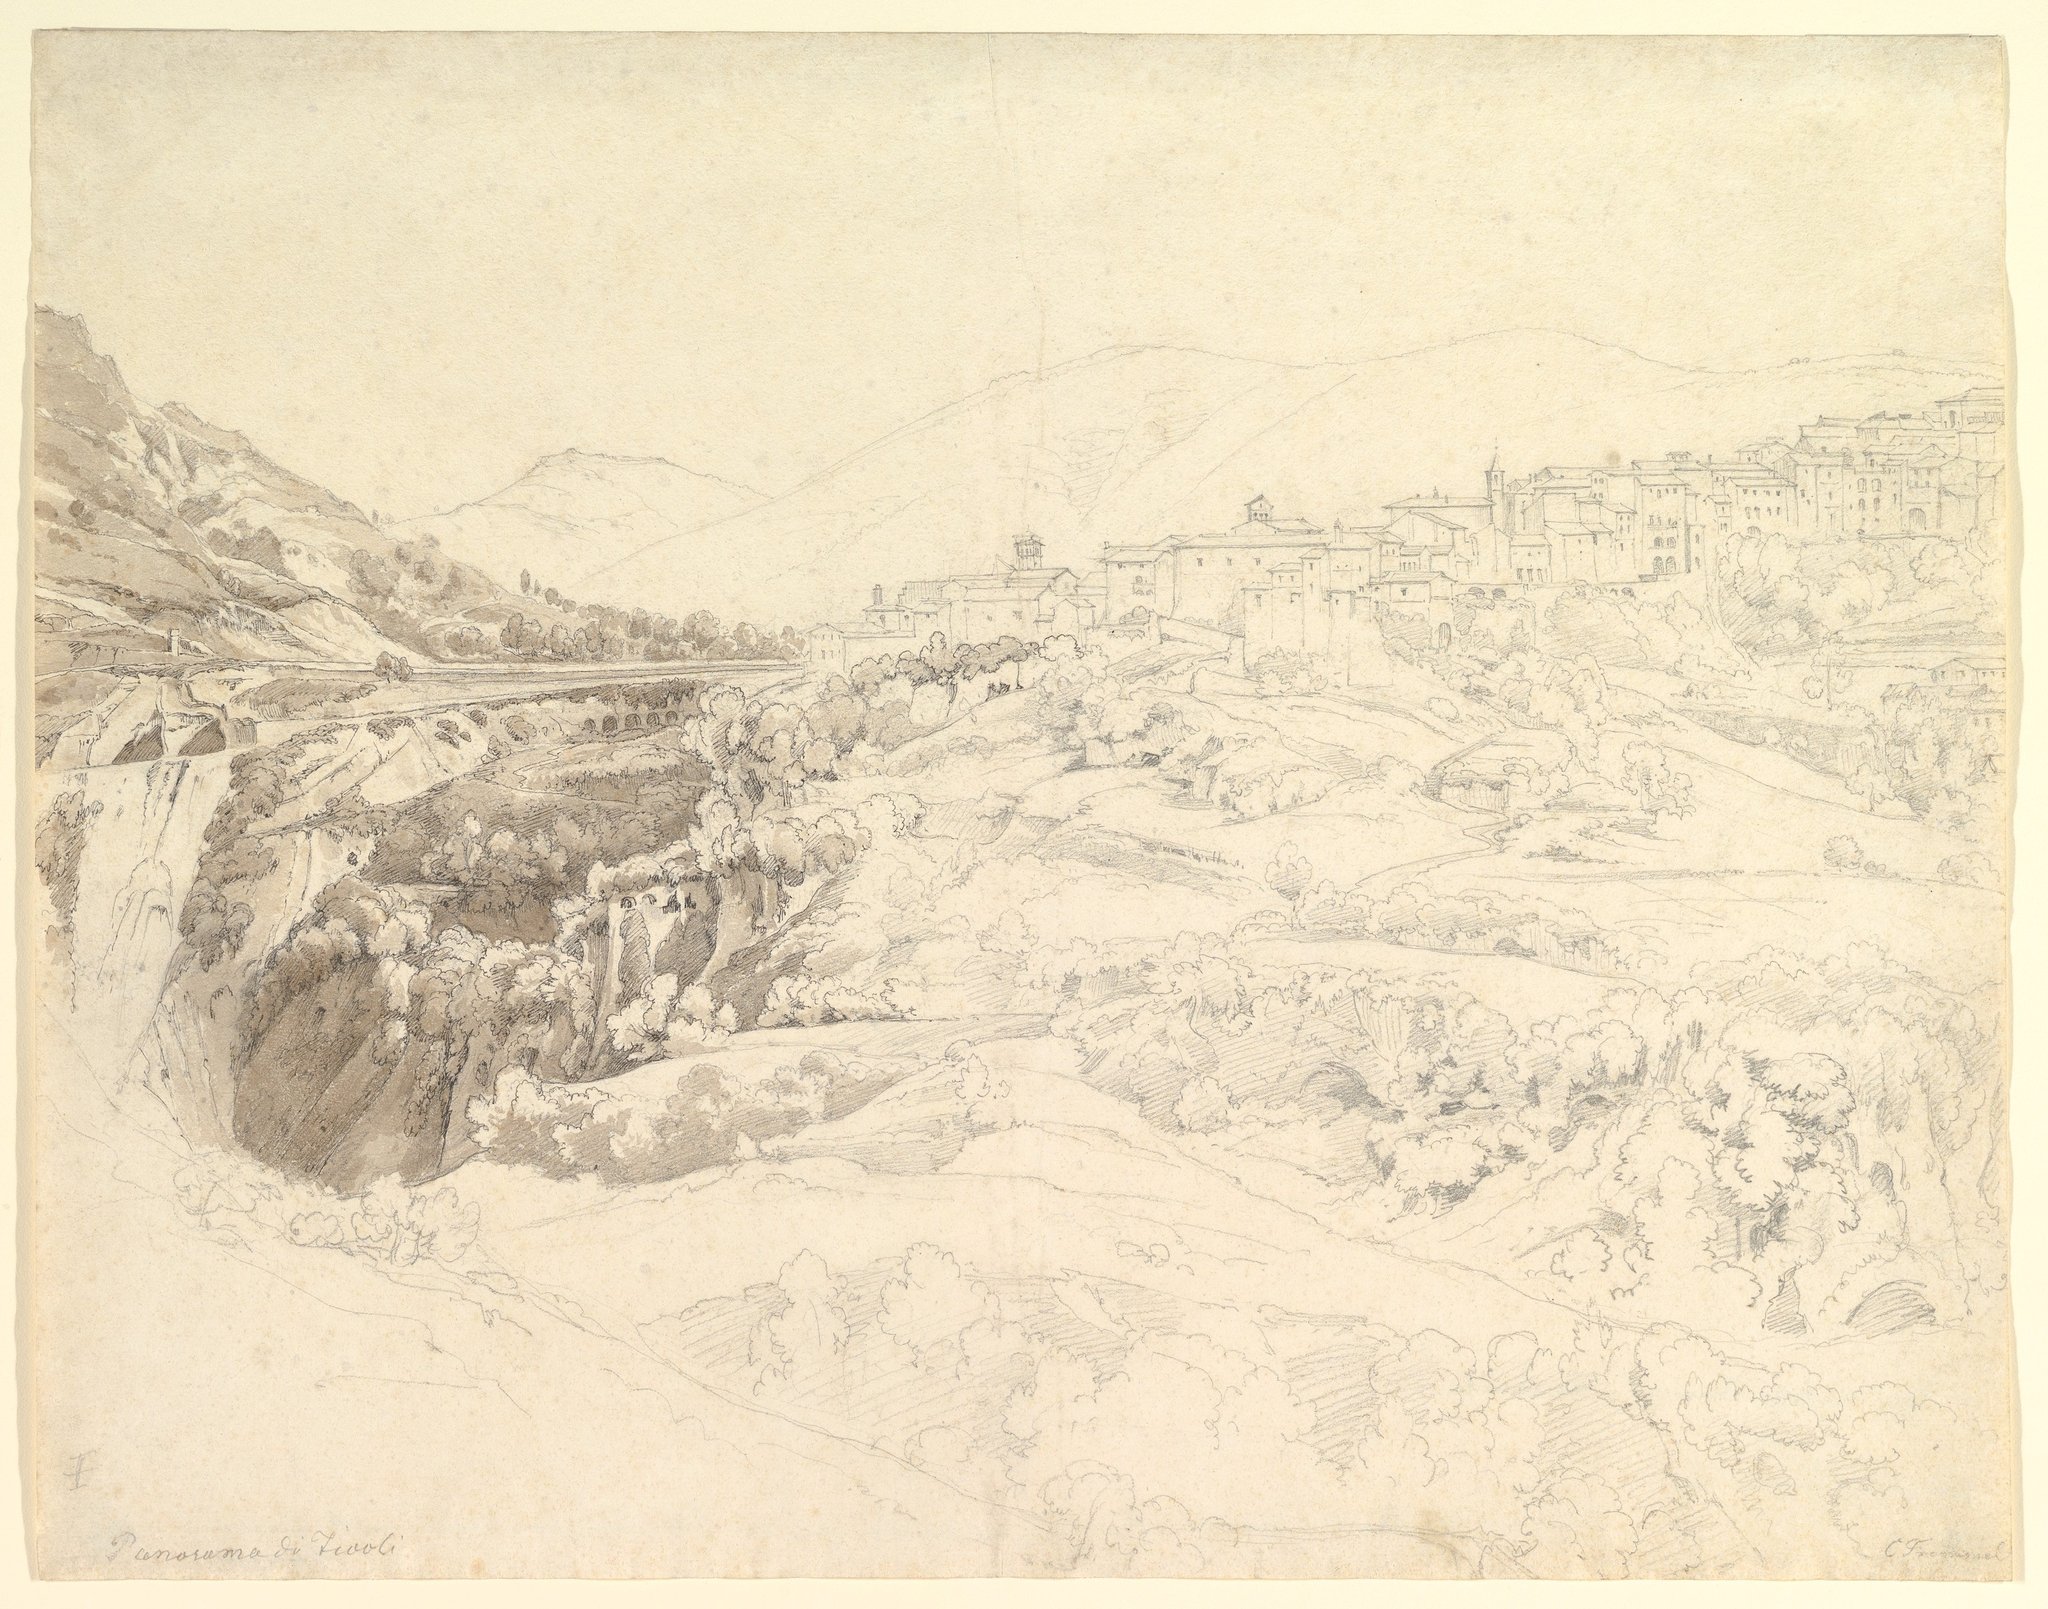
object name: drawing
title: Landscape Near Tivoli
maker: carl ludwig frommel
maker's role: artist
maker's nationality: german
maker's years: 1789-1863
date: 1800-1863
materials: graphite, ink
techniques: brush, pen, wash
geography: germany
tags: buildings,mountains,landscapes